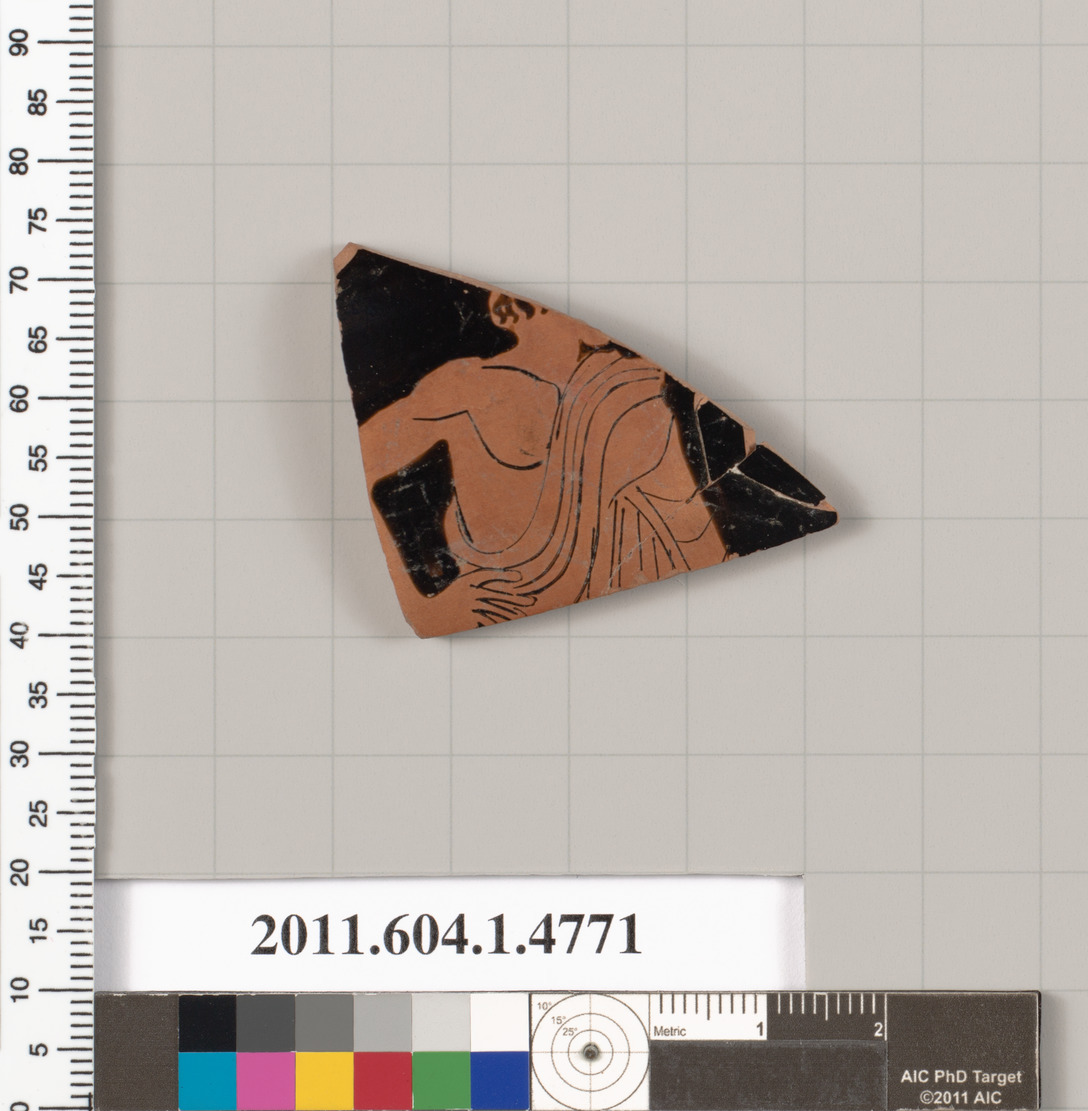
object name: kylix fragment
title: Terracotta fragment of a kylix (drinking cup)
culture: greek, attic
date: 490-470 BCE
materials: terracotta